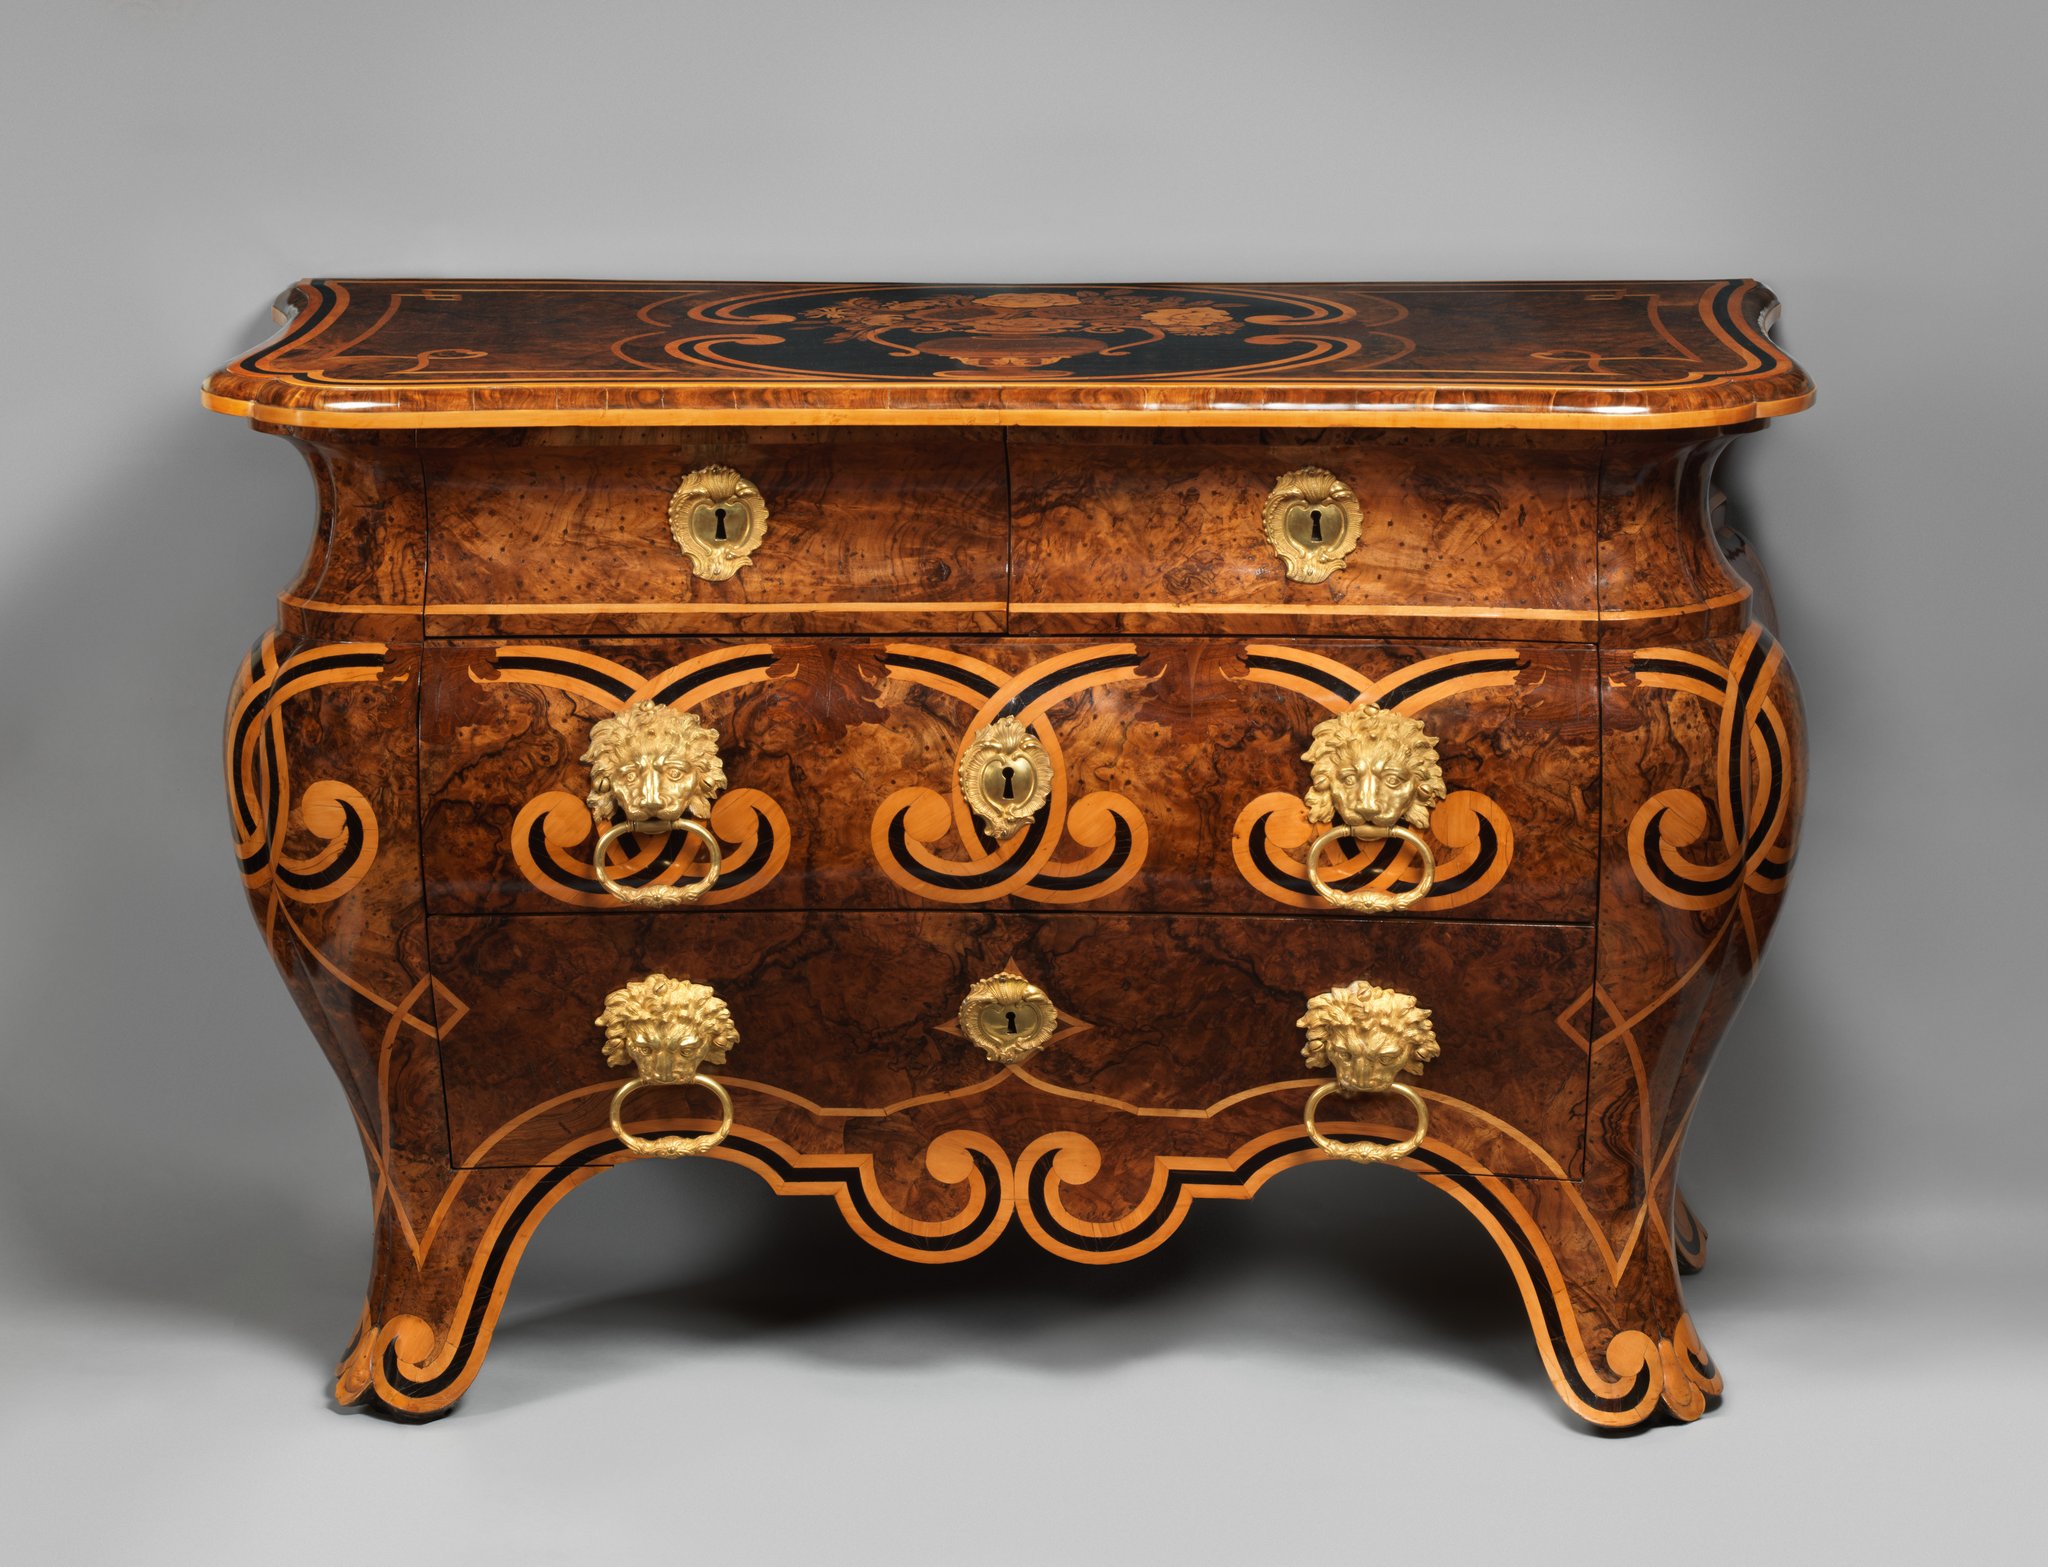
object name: commode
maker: pietro piffetti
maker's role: maker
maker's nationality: italian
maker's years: 1701-1777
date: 1760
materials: wood, gilt bronze, iron